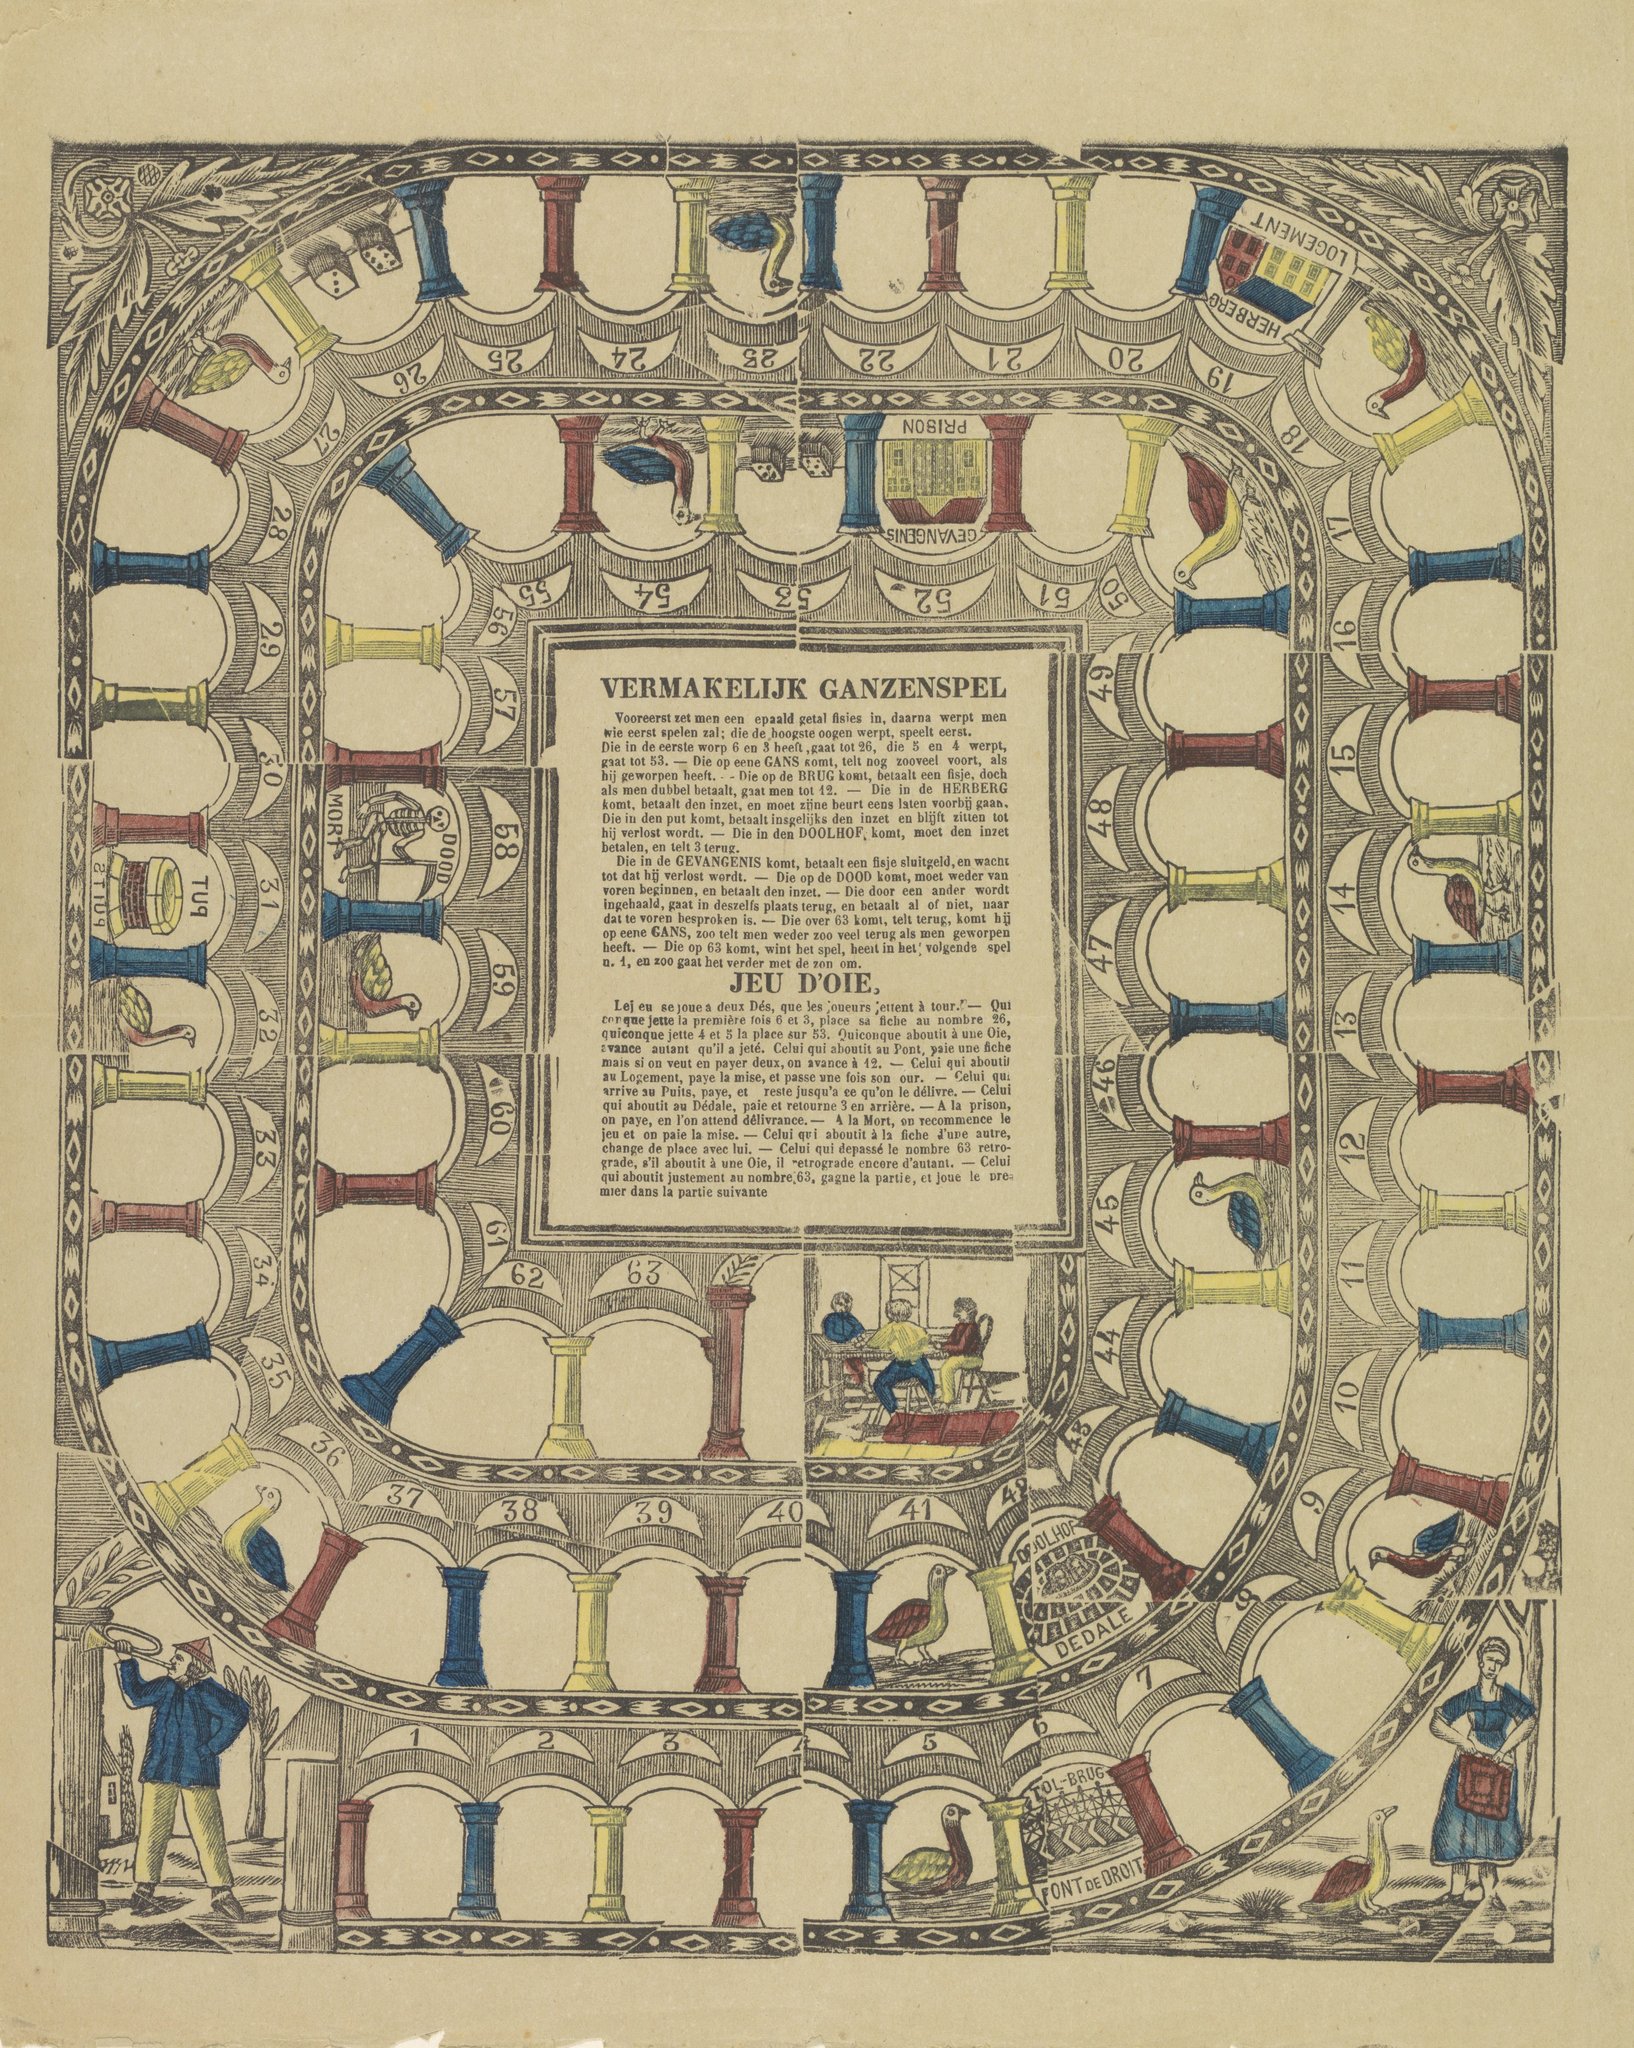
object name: print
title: Vermakelijk ganzenspel / Jeu d'oie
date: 1897-1902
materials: paper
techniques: letterpress printing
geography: turnhout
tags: goose-game, board-games of chance, board-games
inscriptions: collector's mark: Lugt 2760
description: Ganzenbordspel met vakjes genummerd van 1 tot en met 63. In enkele vakjes, die van elkaar gescheiden worden door zuilen die halfronde bogen dragen, voorstellingen van ganzen. In het grote centrale vak de titel en de spelregels in het Nederlands en in het Frans.